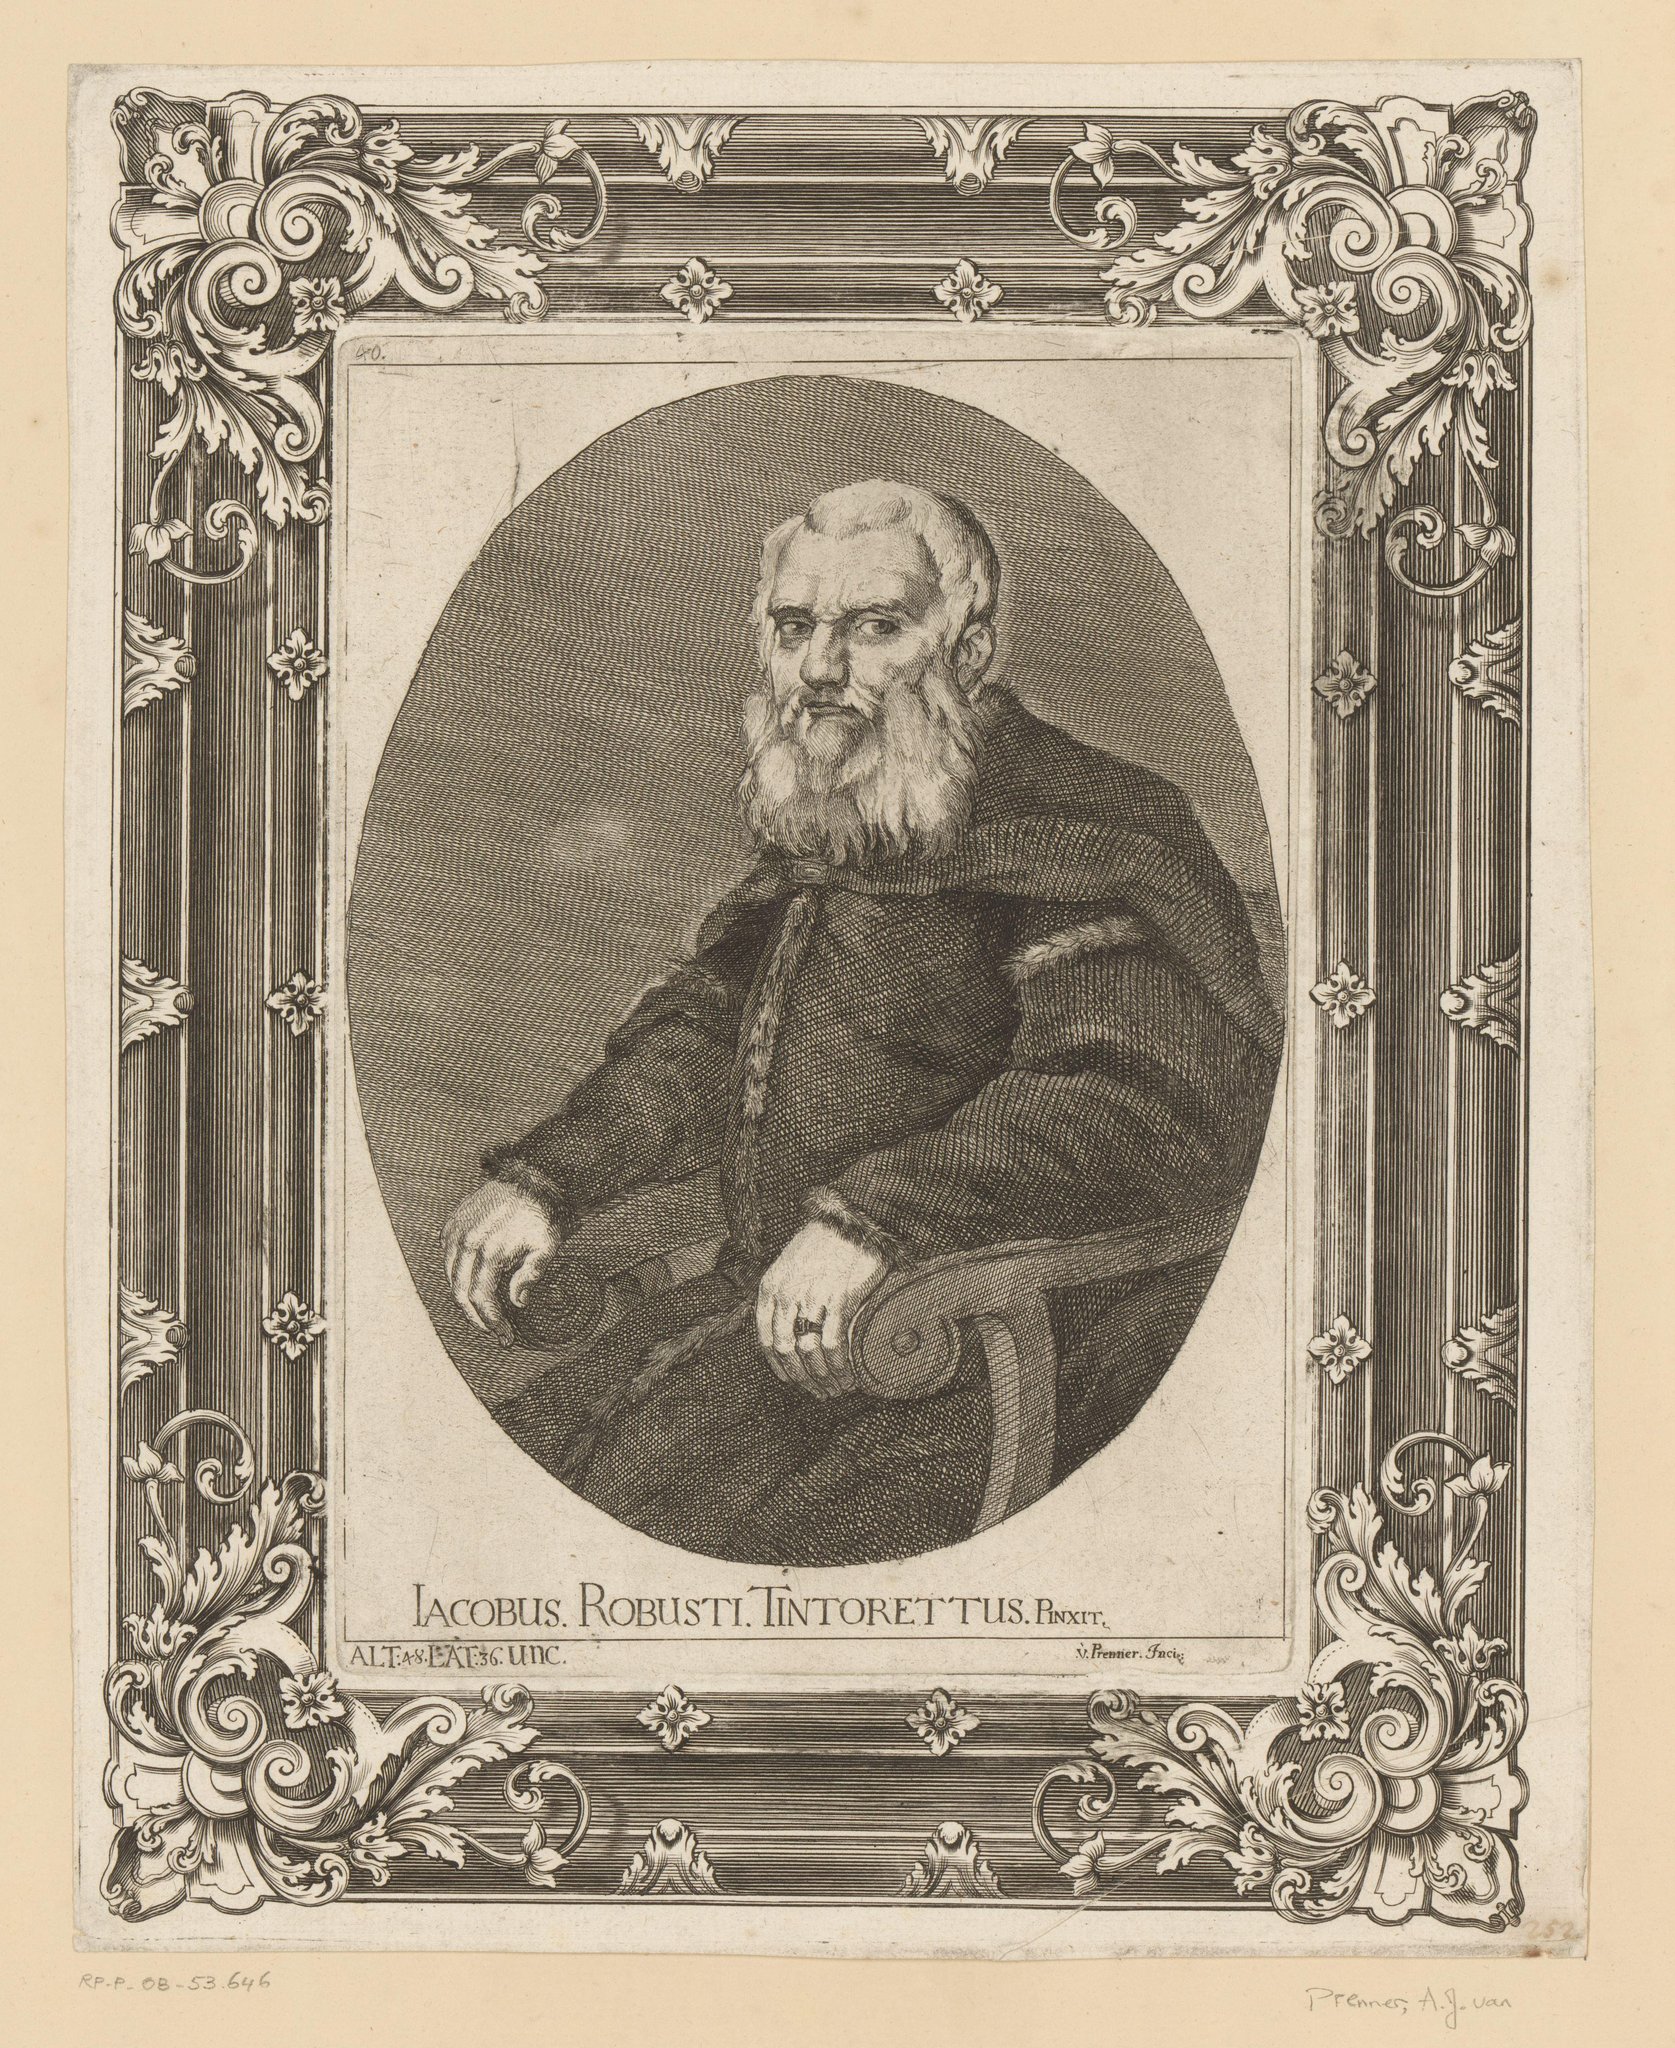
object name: print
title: Portret van een onbekende man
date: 1728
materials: paper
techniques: engraving, etching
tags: venice, painter, print maker, draughtsman, jacopo tintoretto, old man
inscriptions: collector's mark: Lugt 1838, number: ‘252’ Lugt 240, collector's mark:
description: Prent ook gebruikt in: Prenner, Anton Joseph. Theatrum Artis Pictoriae. Wenen: Anton Joseph Prenner, 1728.